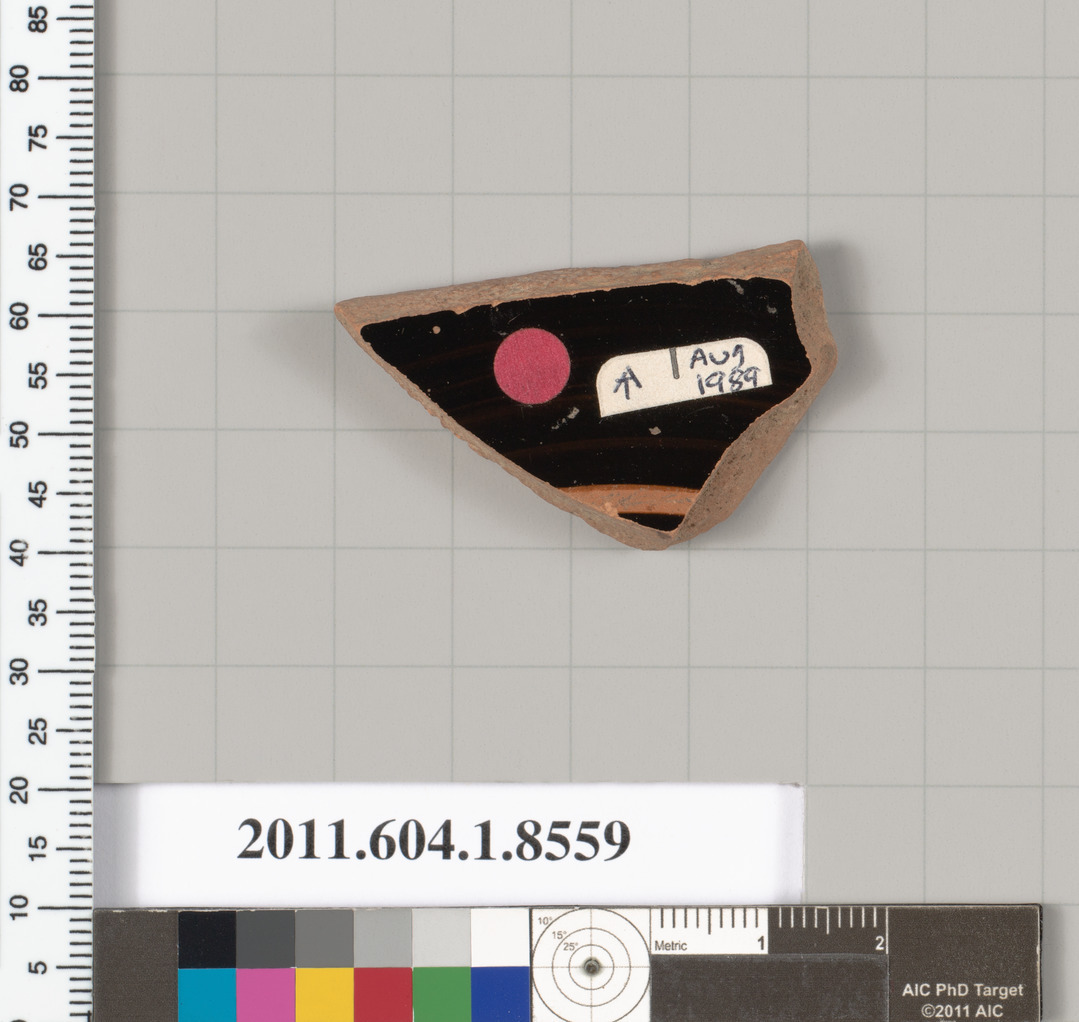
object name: kylix fragment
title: Terracotta fragment of a stemless kylix (drinking cup)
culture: greek, attic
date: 467-435 BCE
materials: terracotta